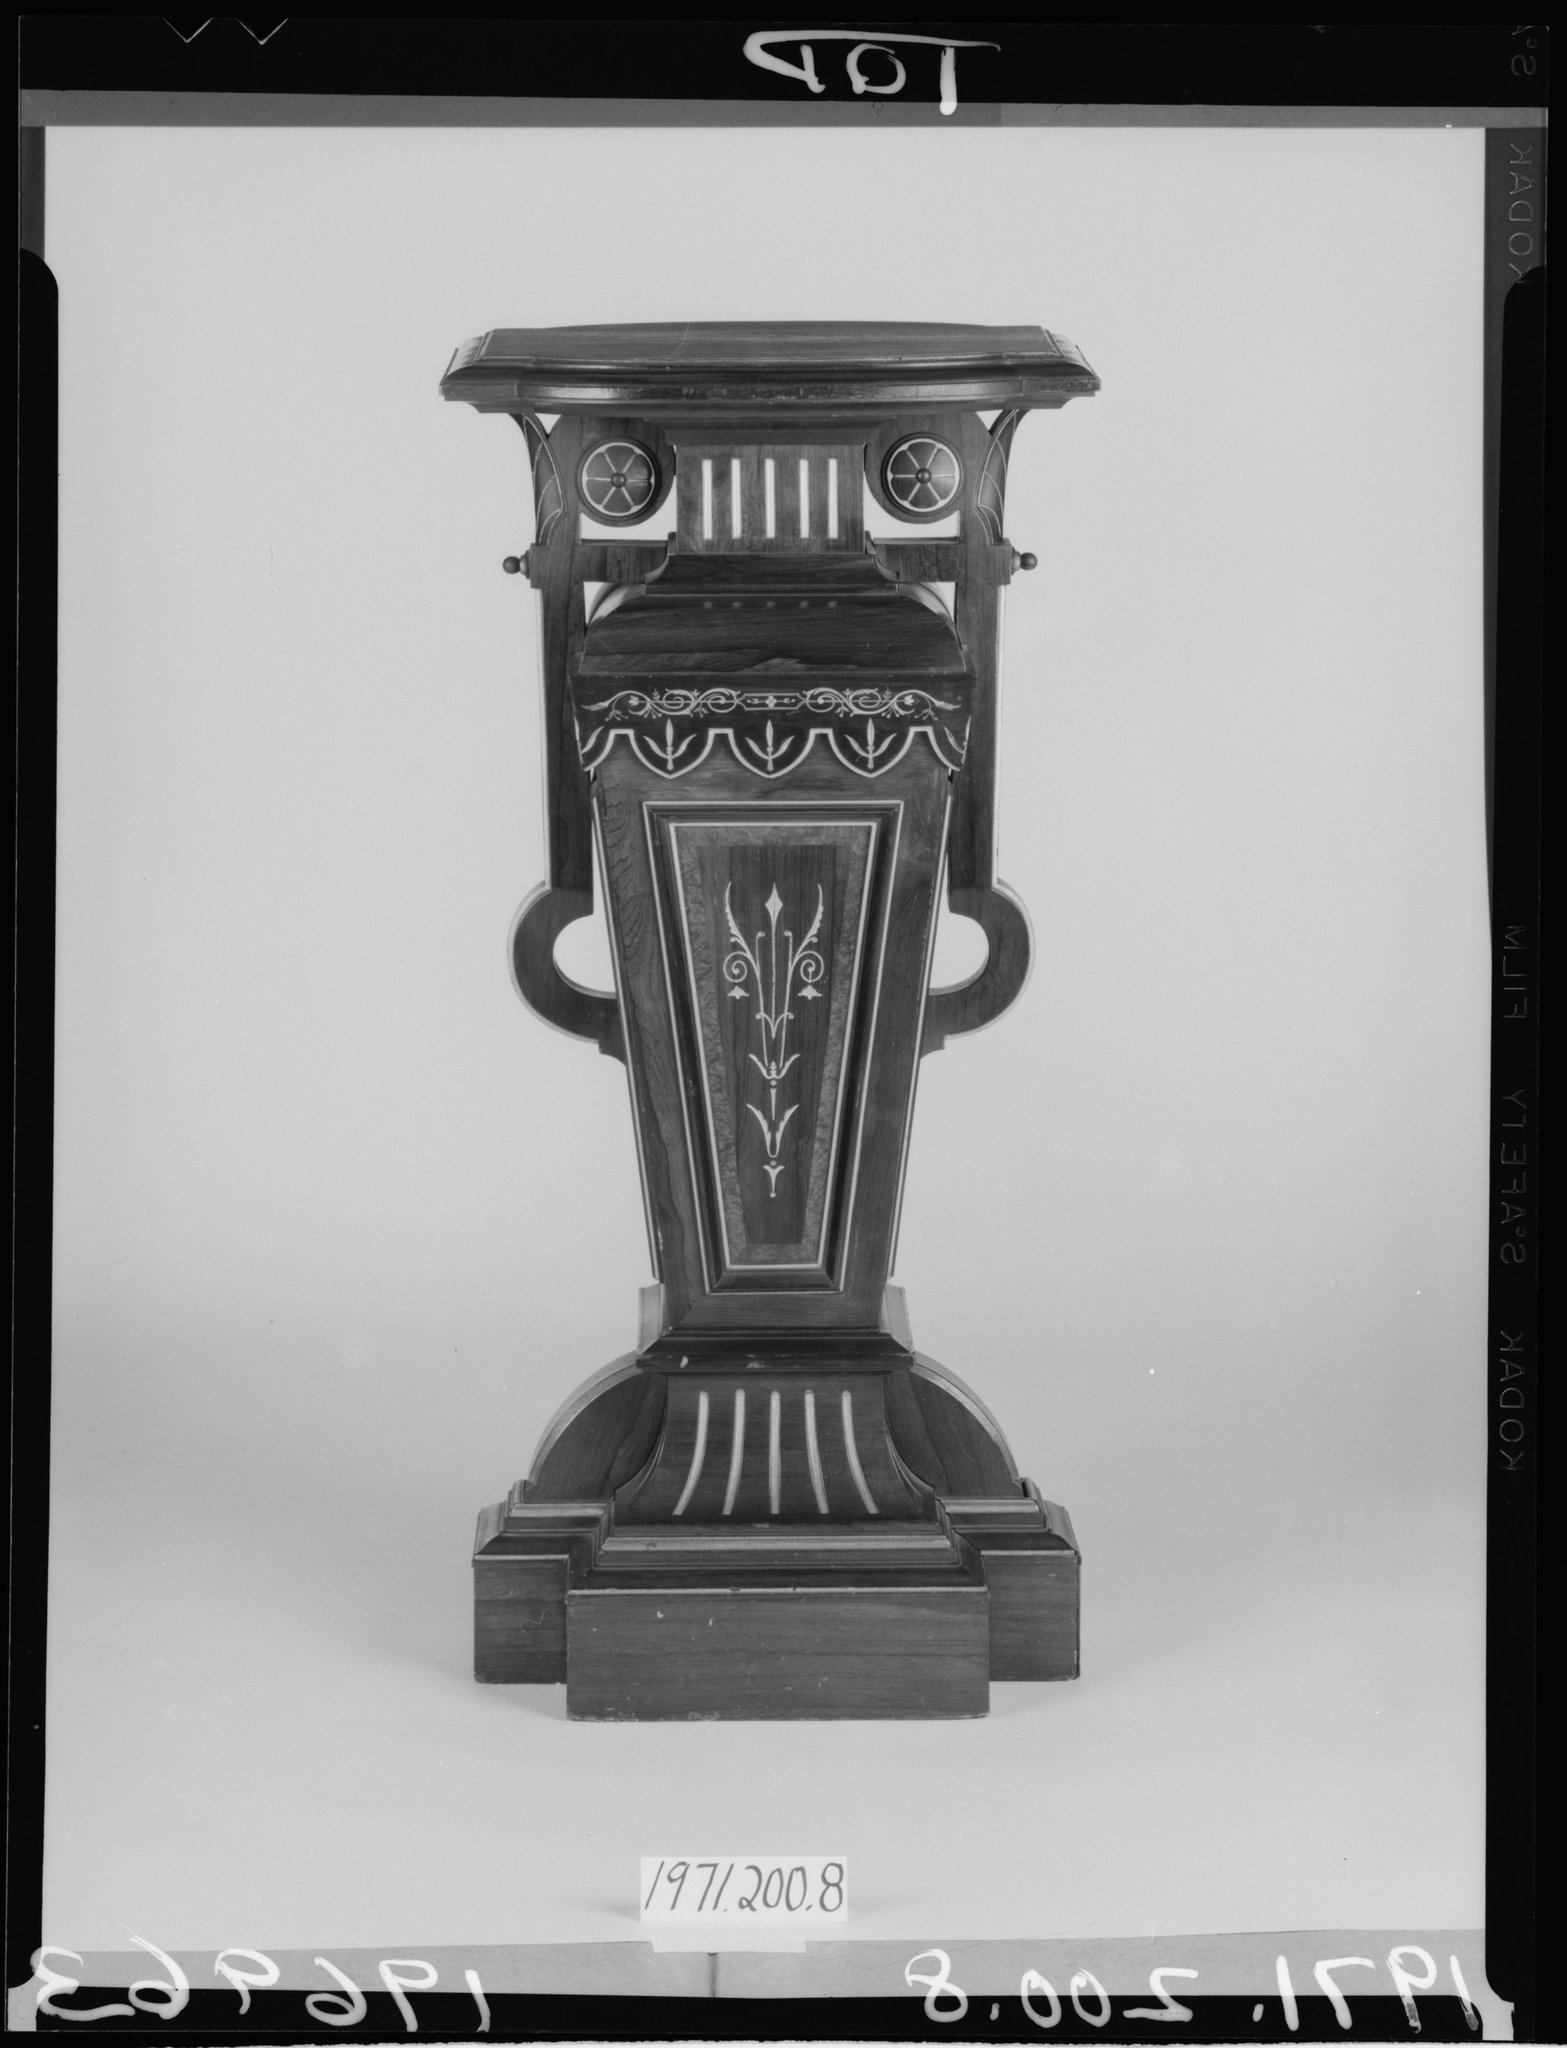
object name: pedestal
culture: american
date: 1870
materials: wood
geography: united states